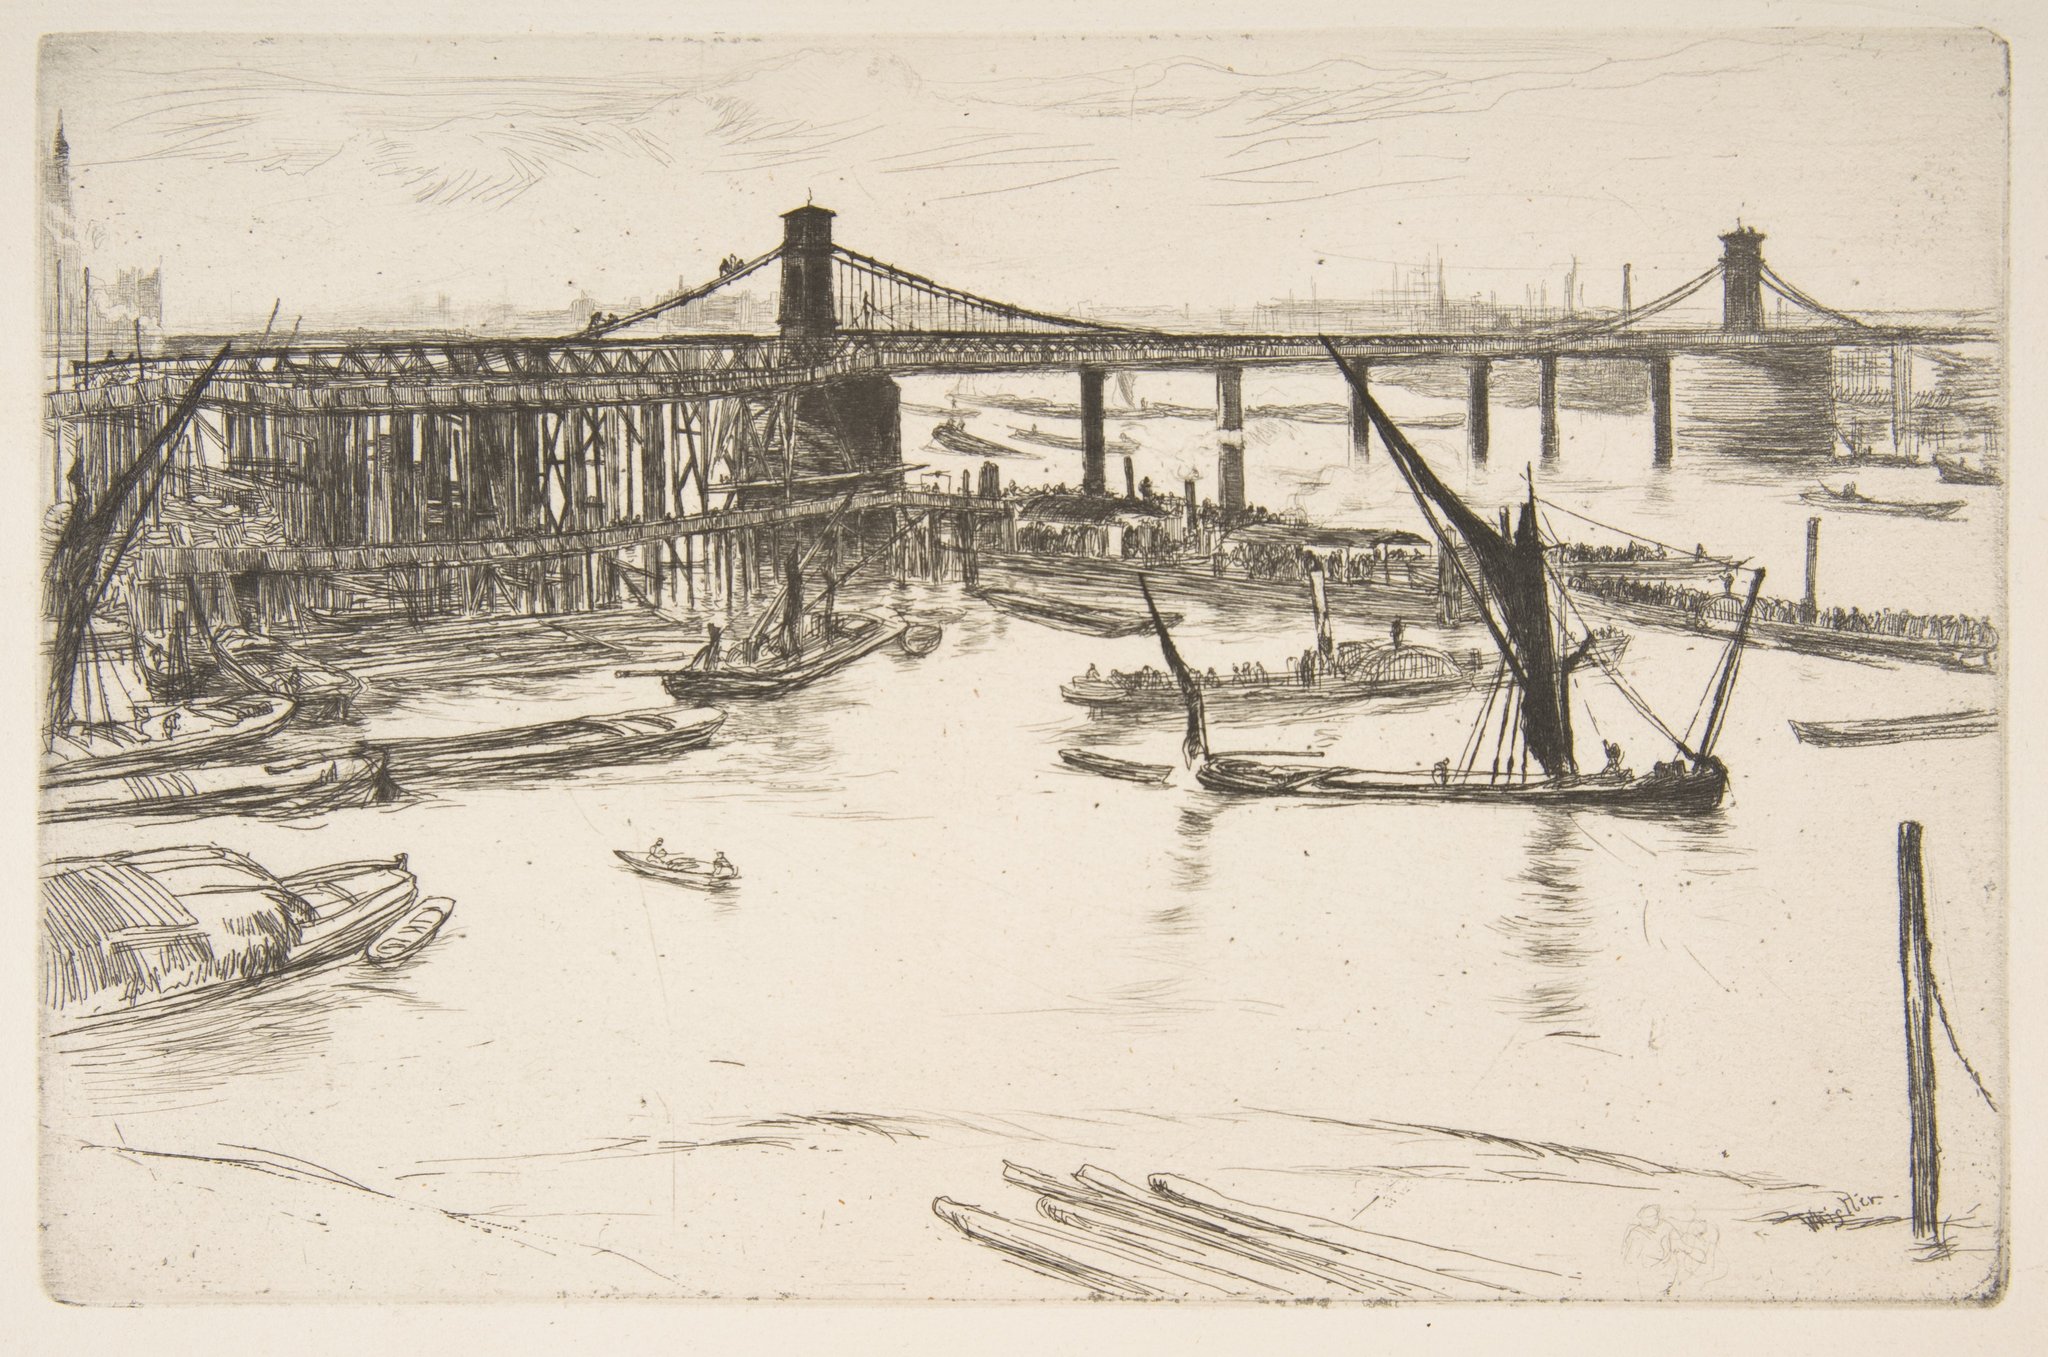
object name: print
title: Old Hungerford Bridge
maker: james mcneill whistler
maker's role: artist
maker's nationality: american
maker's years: 1834-1903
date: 1861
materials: ink, paper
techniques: drypoint, etching, printing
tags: bridges,rivers,boats